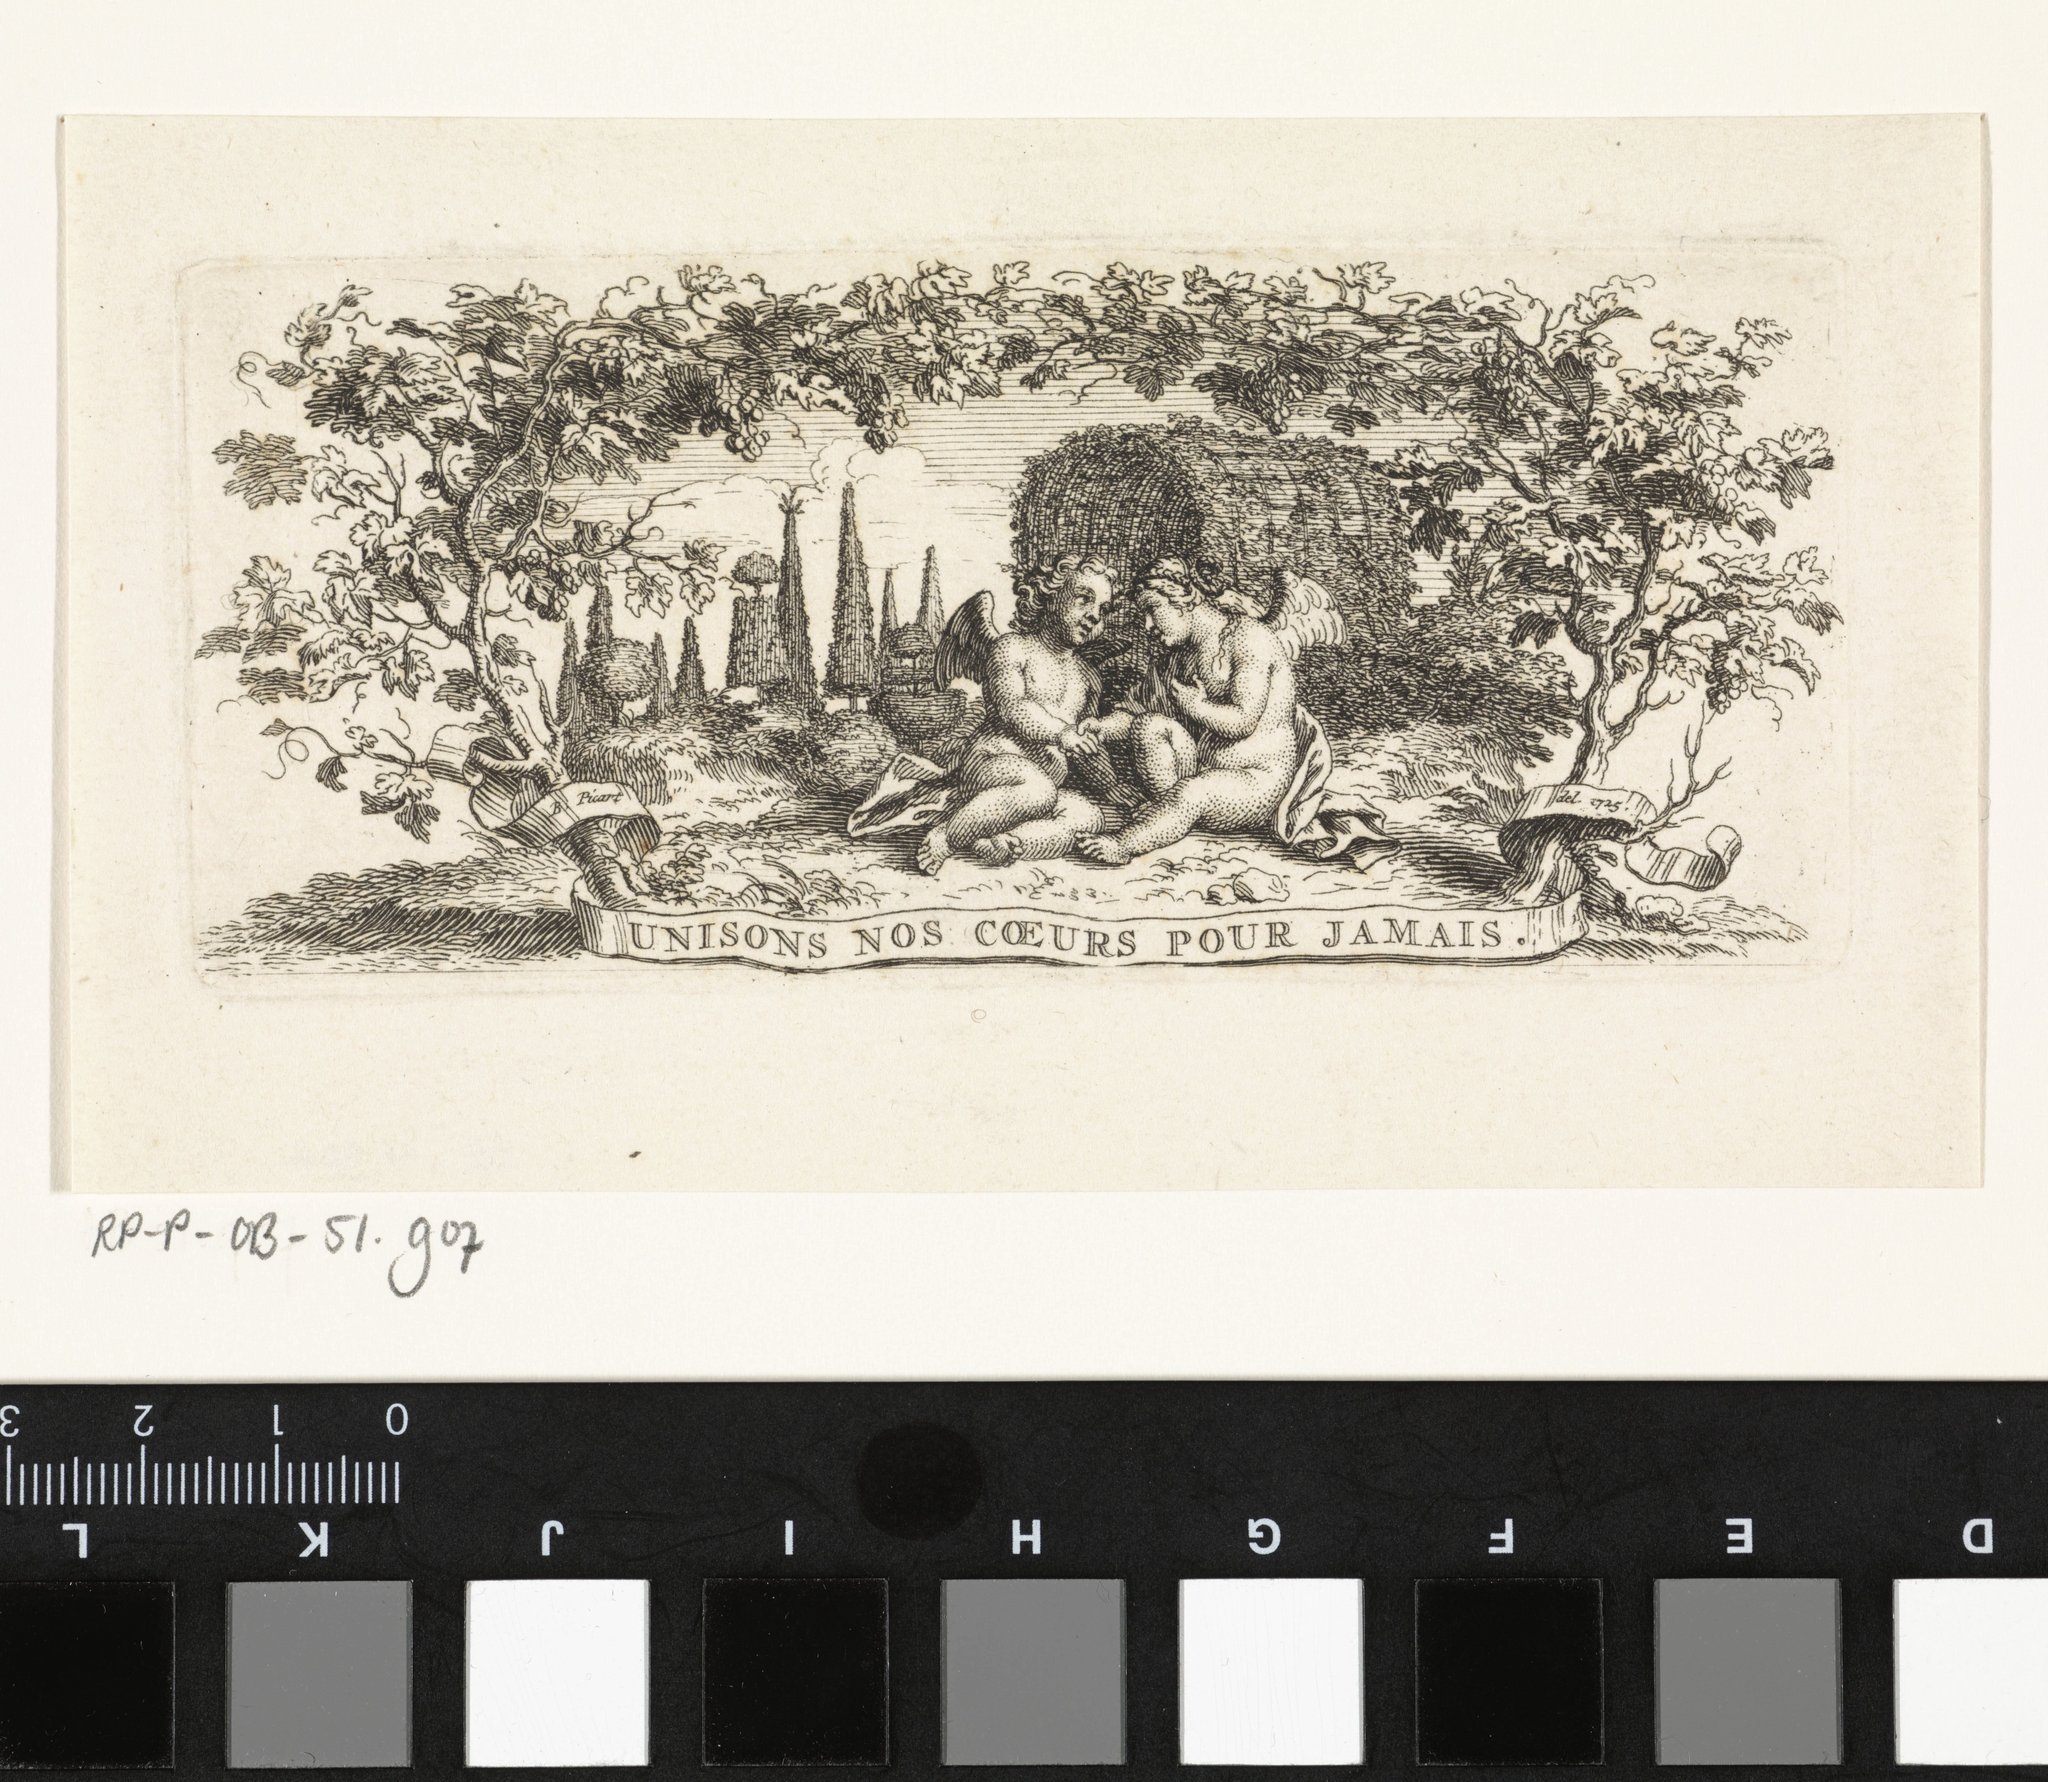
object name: print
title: Twee putti beloven elkaar liefde en trouw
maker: bernard picart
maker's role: draughtsman, print maker, publisher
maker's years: 1673-1733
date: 1725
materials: paper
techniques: engraving, etching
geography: amsterdam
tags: 'omnia vincit amor', love the conqueror, love triumphant (+ variant)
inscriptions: collector's mark: Lugt 2228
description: Een mannelijke en vrouwelijke putto zitten in een tuin en houden elkaars rechterhand vast. Onder de voorstelling het devies: Unisons nos coeurs pour jamais (Verenig onze harten voor altijd).